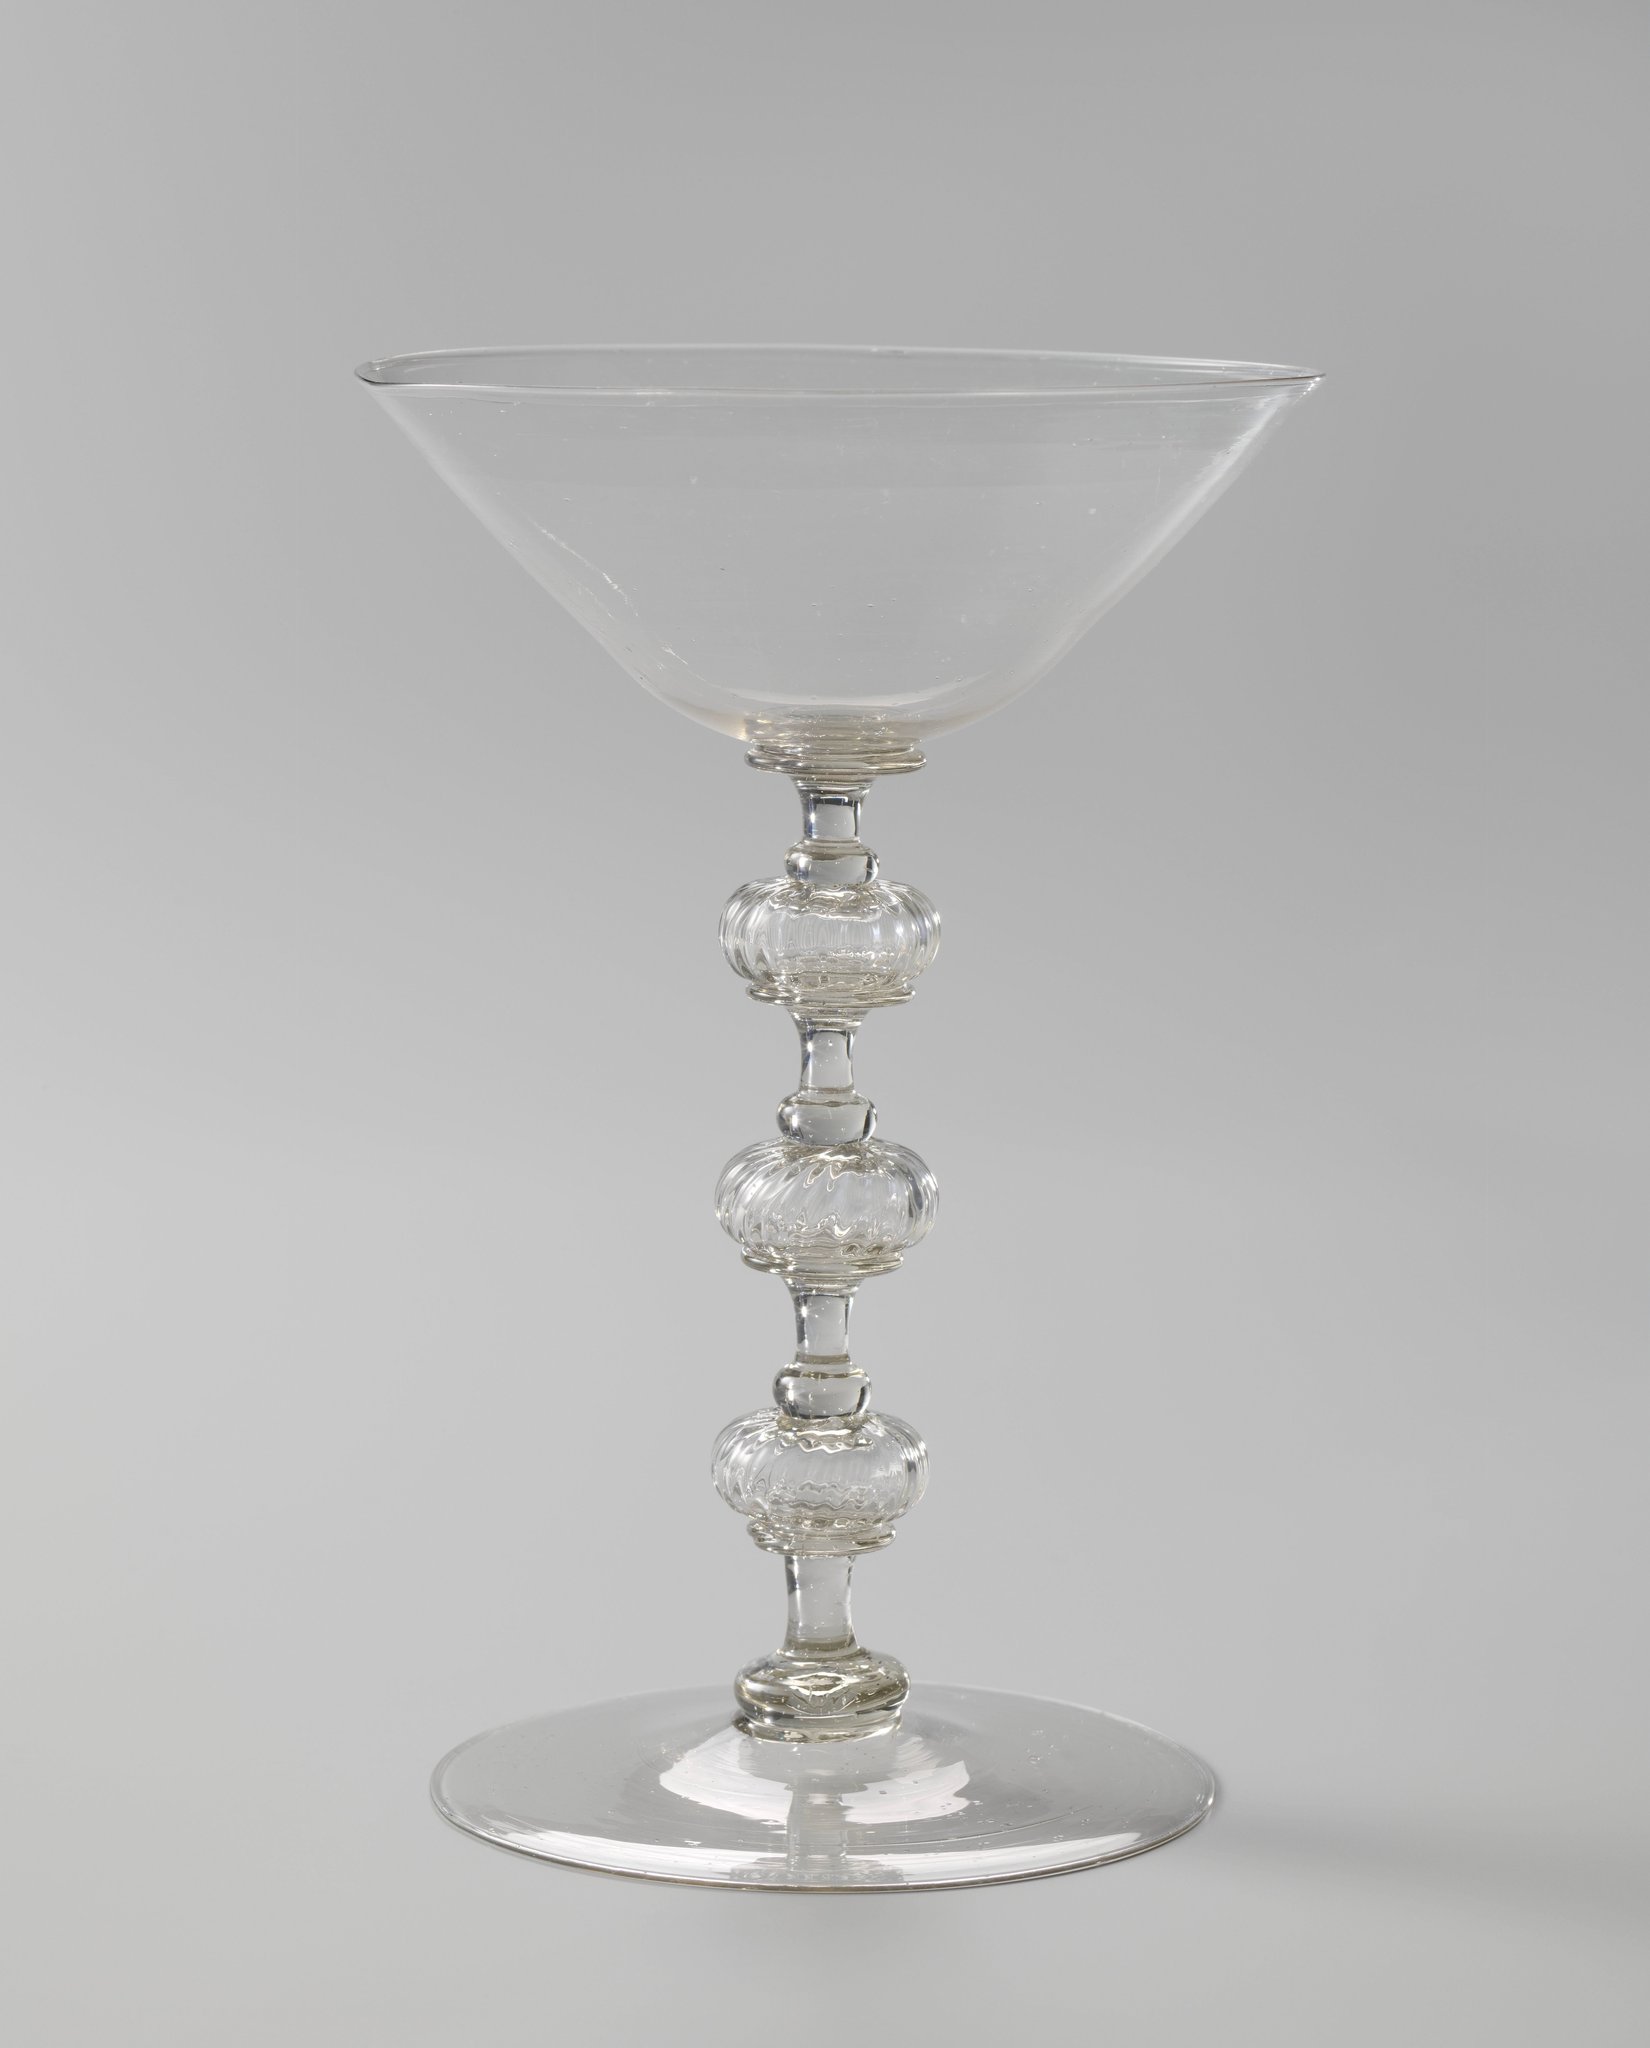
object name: goblet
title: Kelkglas met een trechtervormige kelk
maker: Anonymous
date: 1600-1699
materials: glass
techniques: façon de venise, glassblowing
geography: low countries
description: Platte voet. De stam opgebouwd uit drie holle, geribde nodi, vier gladde verbindingsstukken, drie gladde nodi en vier schijven. Wijde, trechtervormige, aan de onderzijde afgeronde kelk.